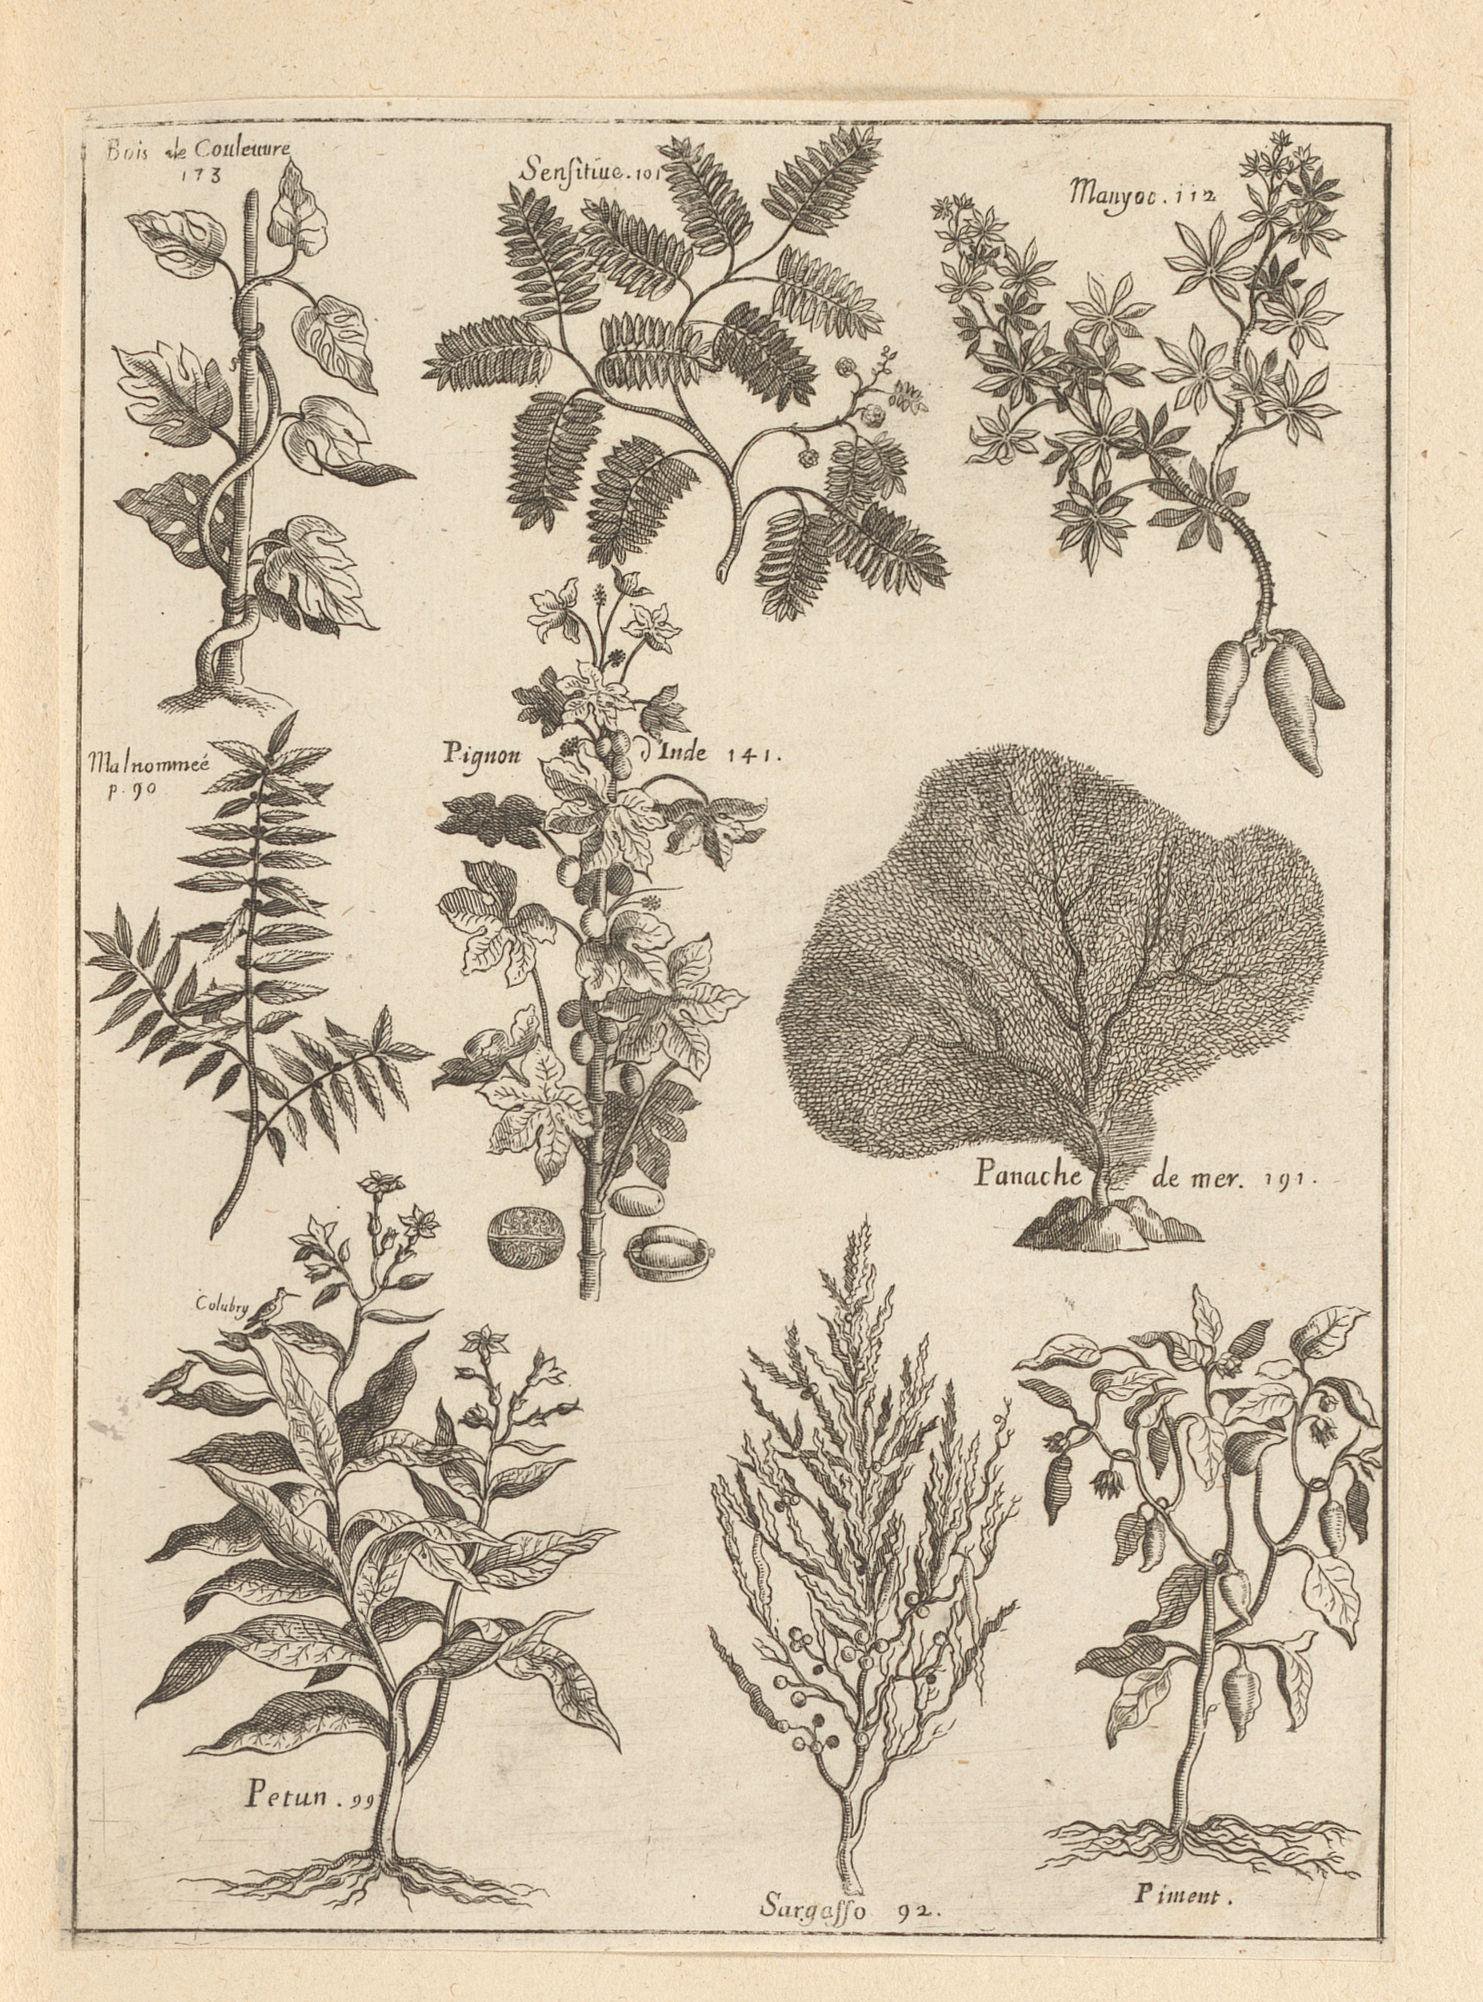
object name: print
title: Verschillende planten en struiken van de Franse Antillen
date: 1667-1671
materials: paper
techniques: etching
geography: paris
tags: plants (in general), coelenterata: coral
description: Verschillende inheemse planten en struiken, allen vergezeld door de naam van de plant op de plaat. Prent maakt deel uit van een album.